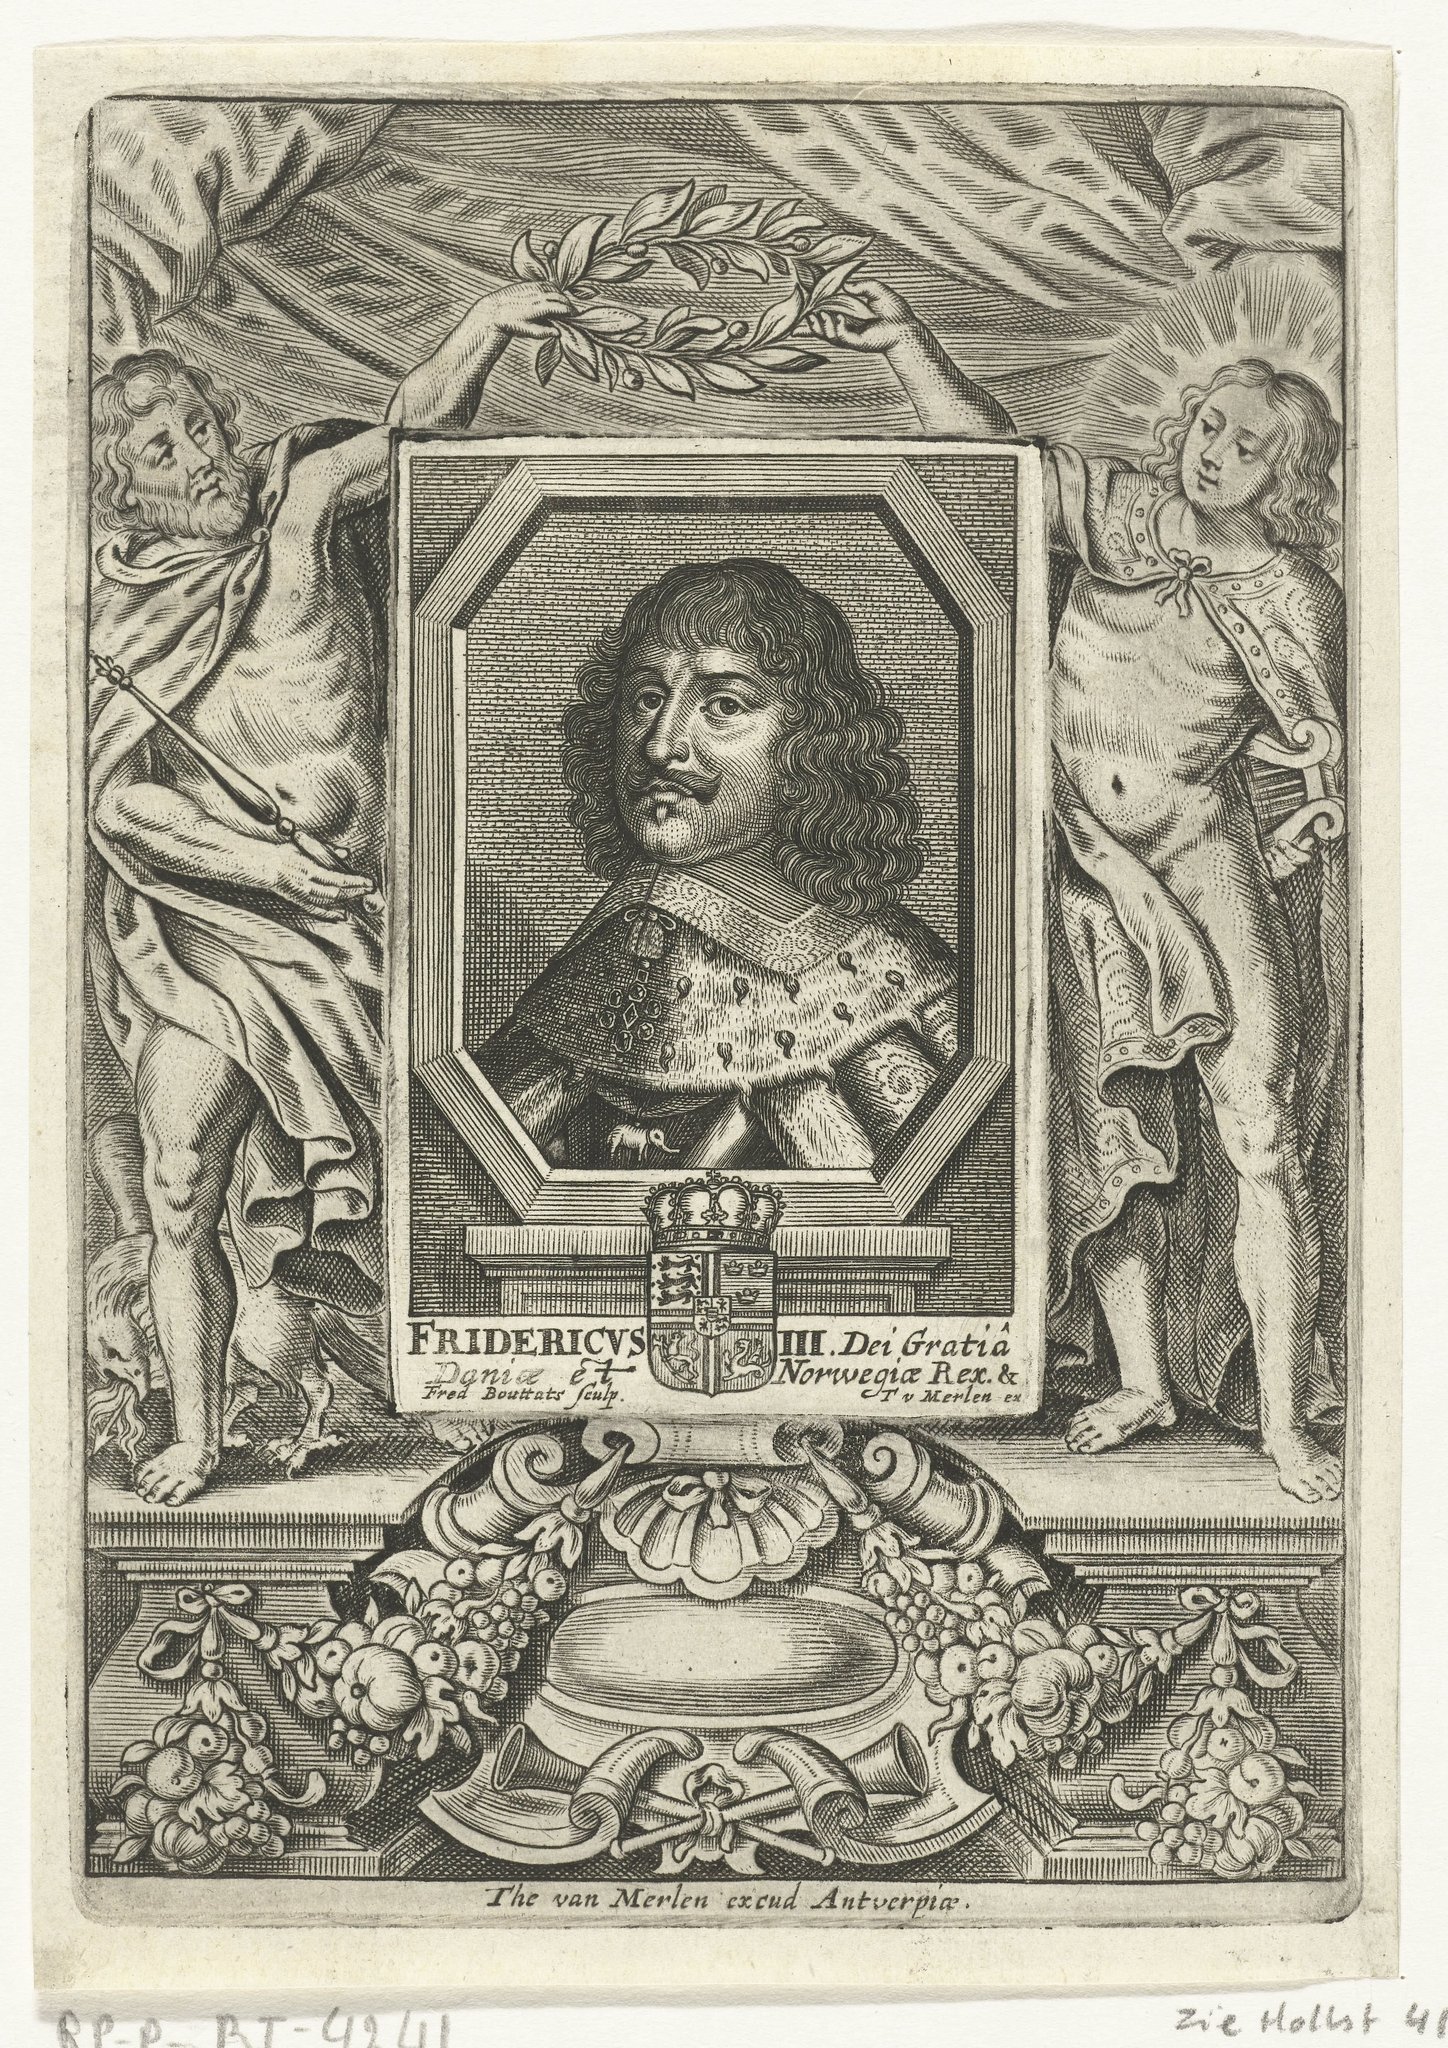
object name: print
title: Portret van Frederik III van Denemarken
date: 1648-1676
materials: paper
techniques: engraving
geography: antwerp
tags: copenhagen (city), frederik iii (koning van denemarken en noorwegen), (story of) apollo (phoebus), (story of) jupiter (zeus)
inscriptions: collector's mark: Lugt 2228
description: Portret in een octagonale lijst van Frederik III, koning van Denemarken en Noorwegen. Buste naar links. Frederik III draagt een hermelijnen mantel. Het portret staat in een rechthoekig kader tussen twee klassieke goden, Jupiter en Apollo. Ze houden een lauwerkrans boven het portret.. De prent heeft een Latijns onderschrift met de naam van de geportretteerde.